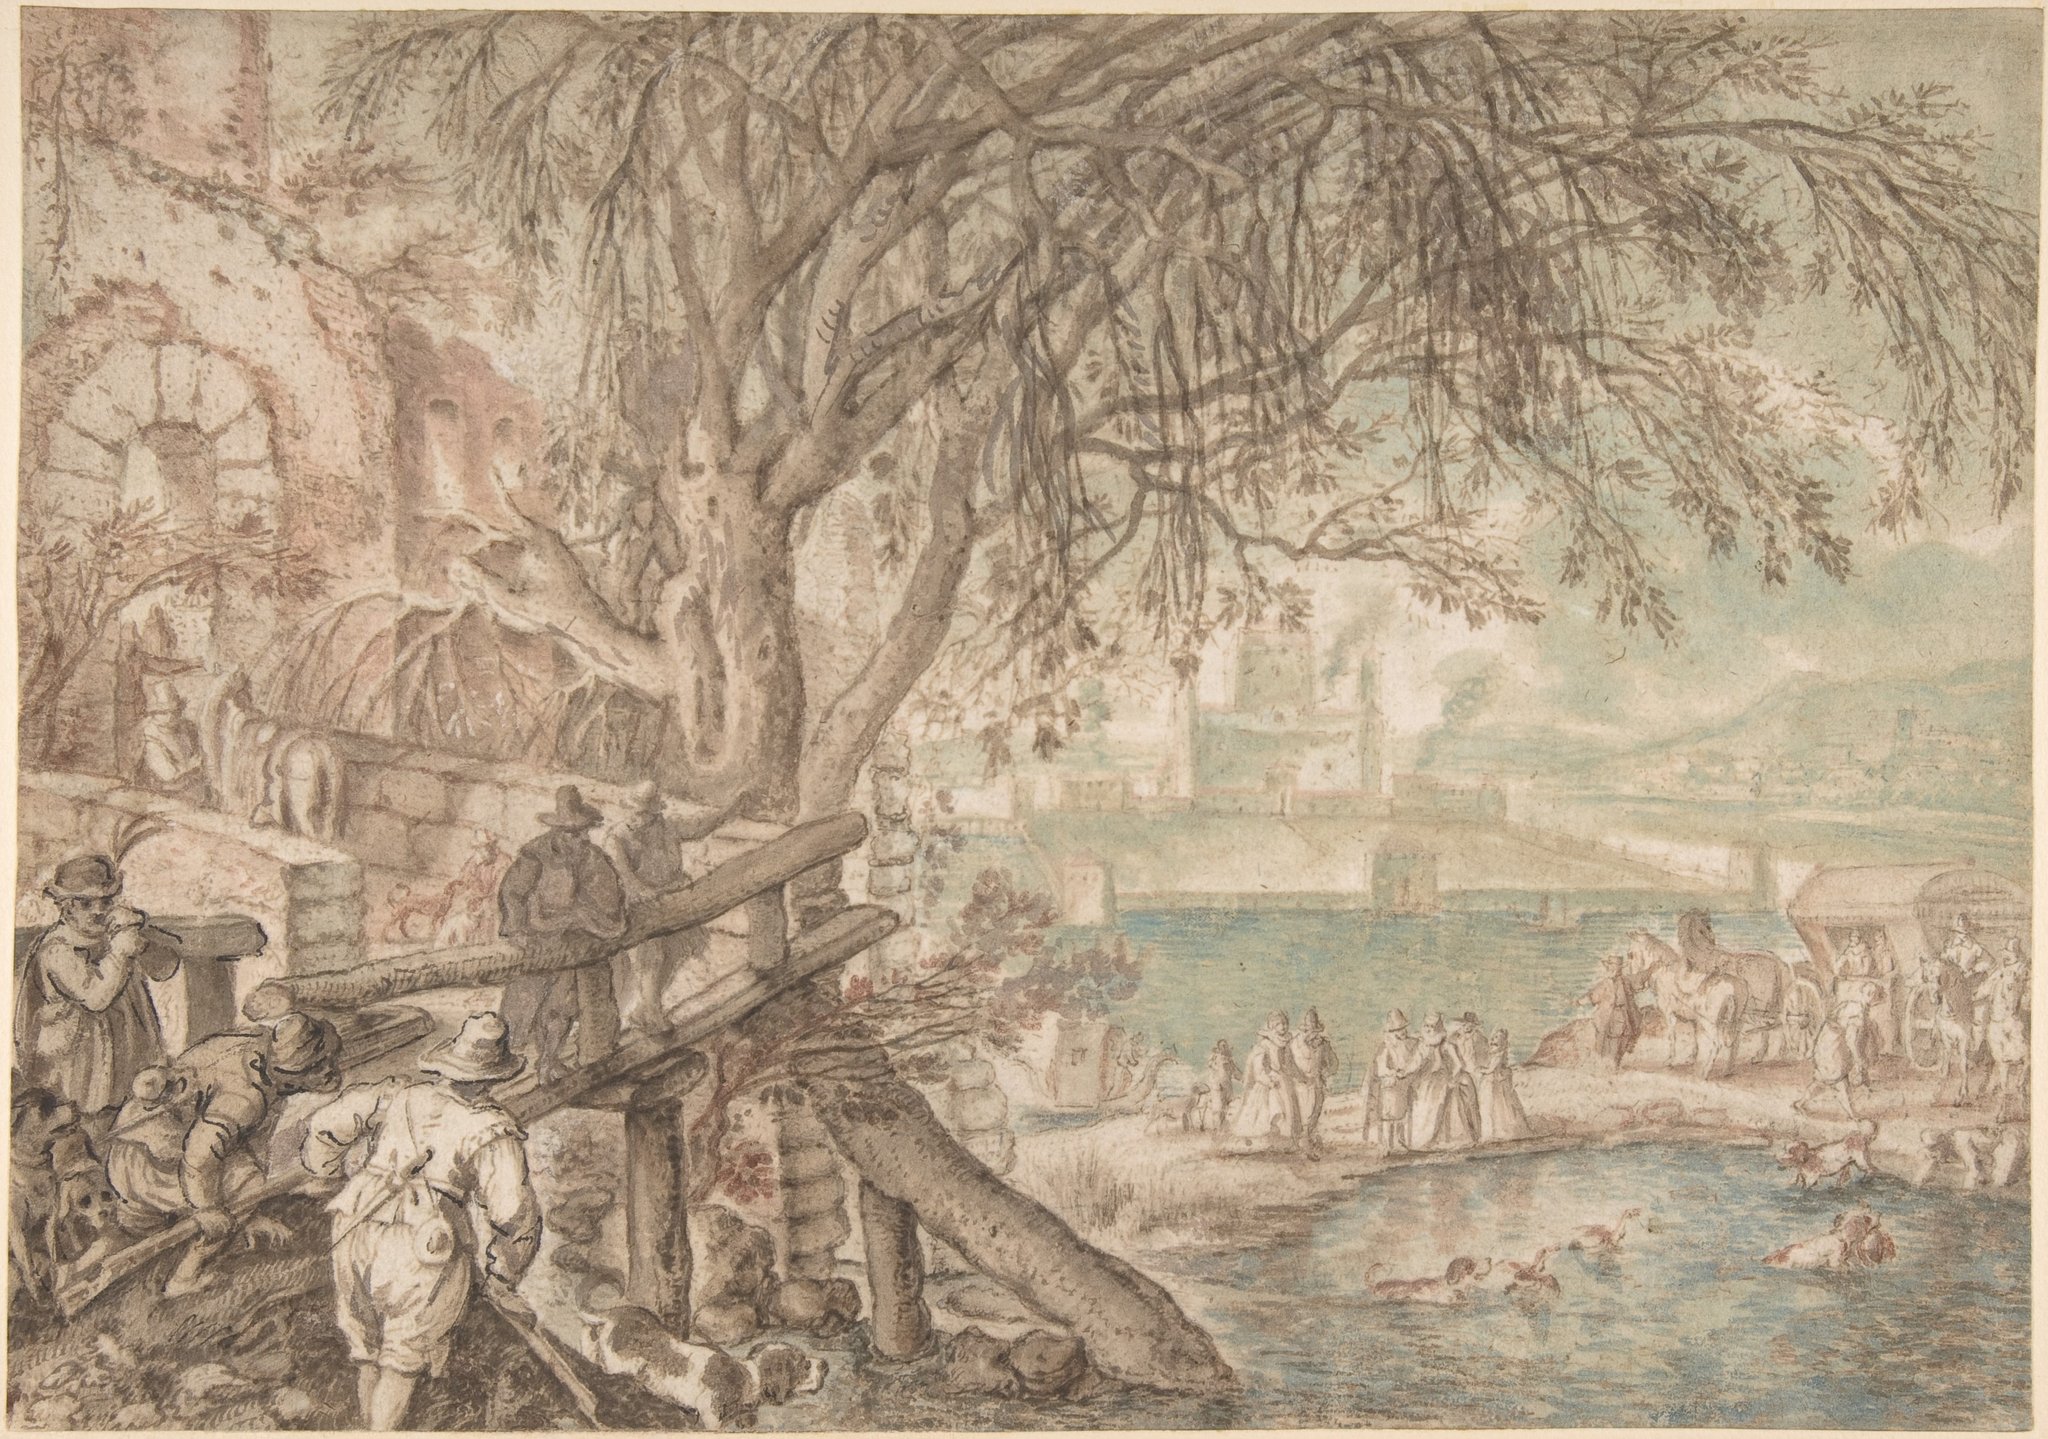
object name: drawing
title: Huntsmen and Company Observing Dogs Retrieving Ducks in a Pond (The Month of April)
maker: pieter stevens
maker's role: artist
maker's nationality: netherlandish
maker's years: 1567-1624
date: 1610-1620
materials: chalk, gouache, ink, watercolor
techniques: pen, wash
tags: ducks,men,women,dogs,horses,ponds,trees